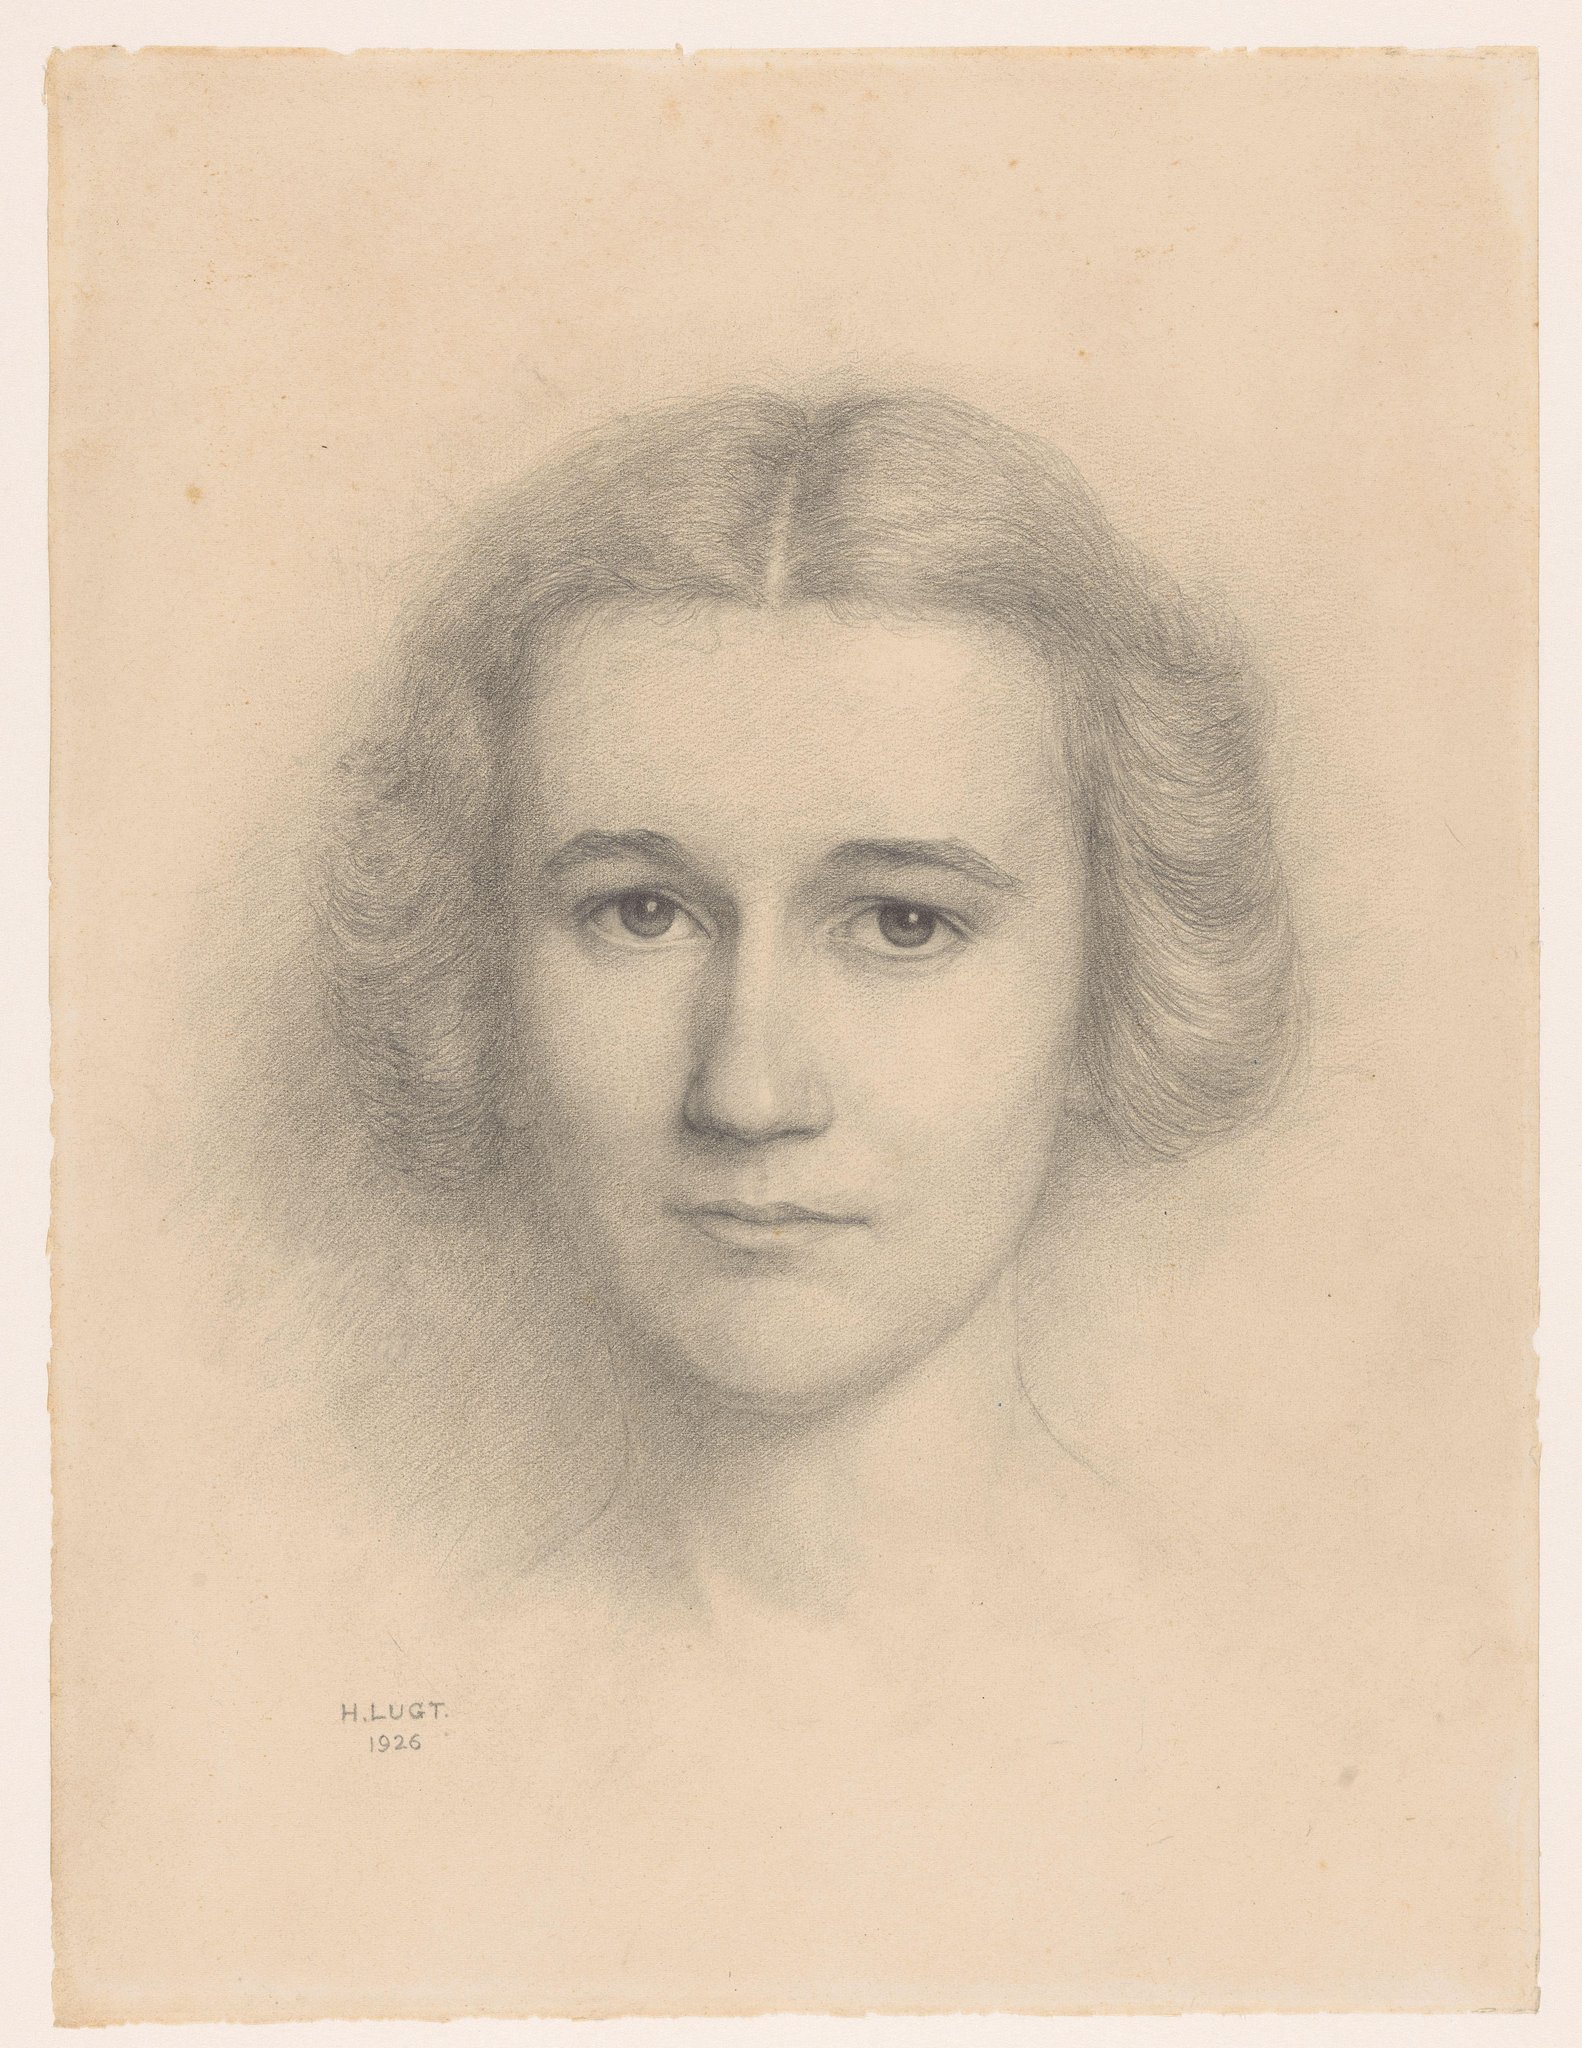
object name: drawing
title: Portret van To van der Sluys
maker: herman lugt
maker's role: draughtsman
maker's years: 1881-1950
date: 1926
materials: paper, pencil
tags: historical persons, female singer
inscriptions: date